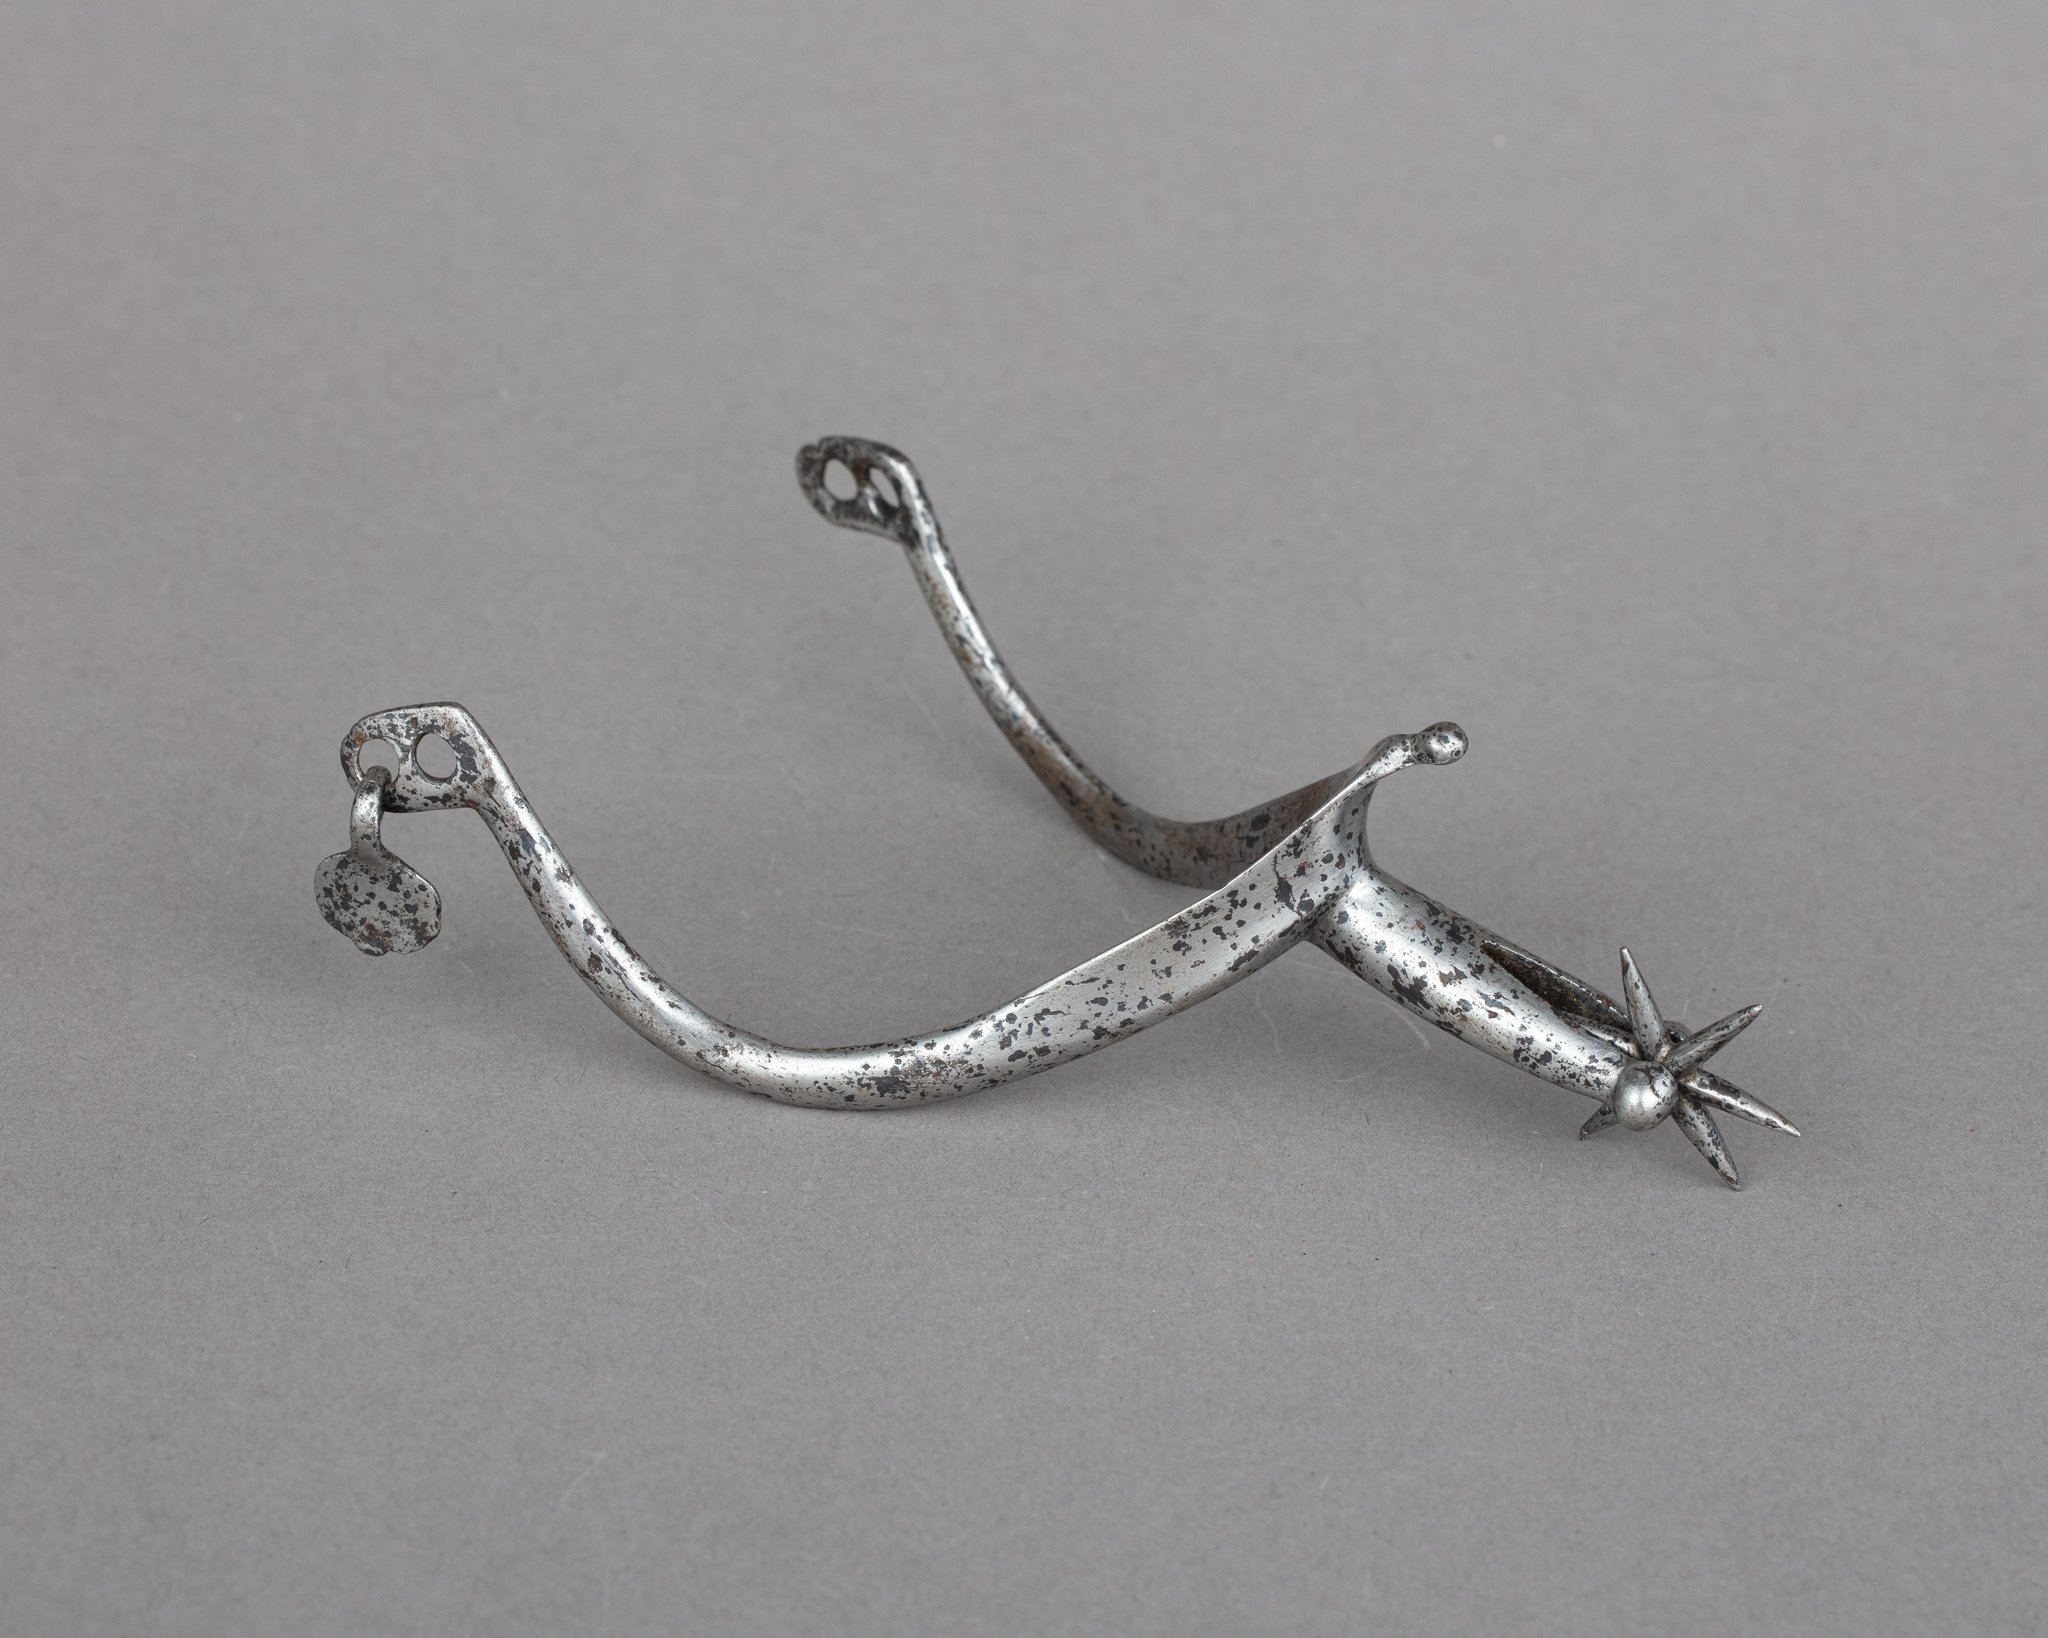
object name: spur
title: Rowel Spur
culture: italian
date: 1367-1400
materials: metal alloy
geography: italy